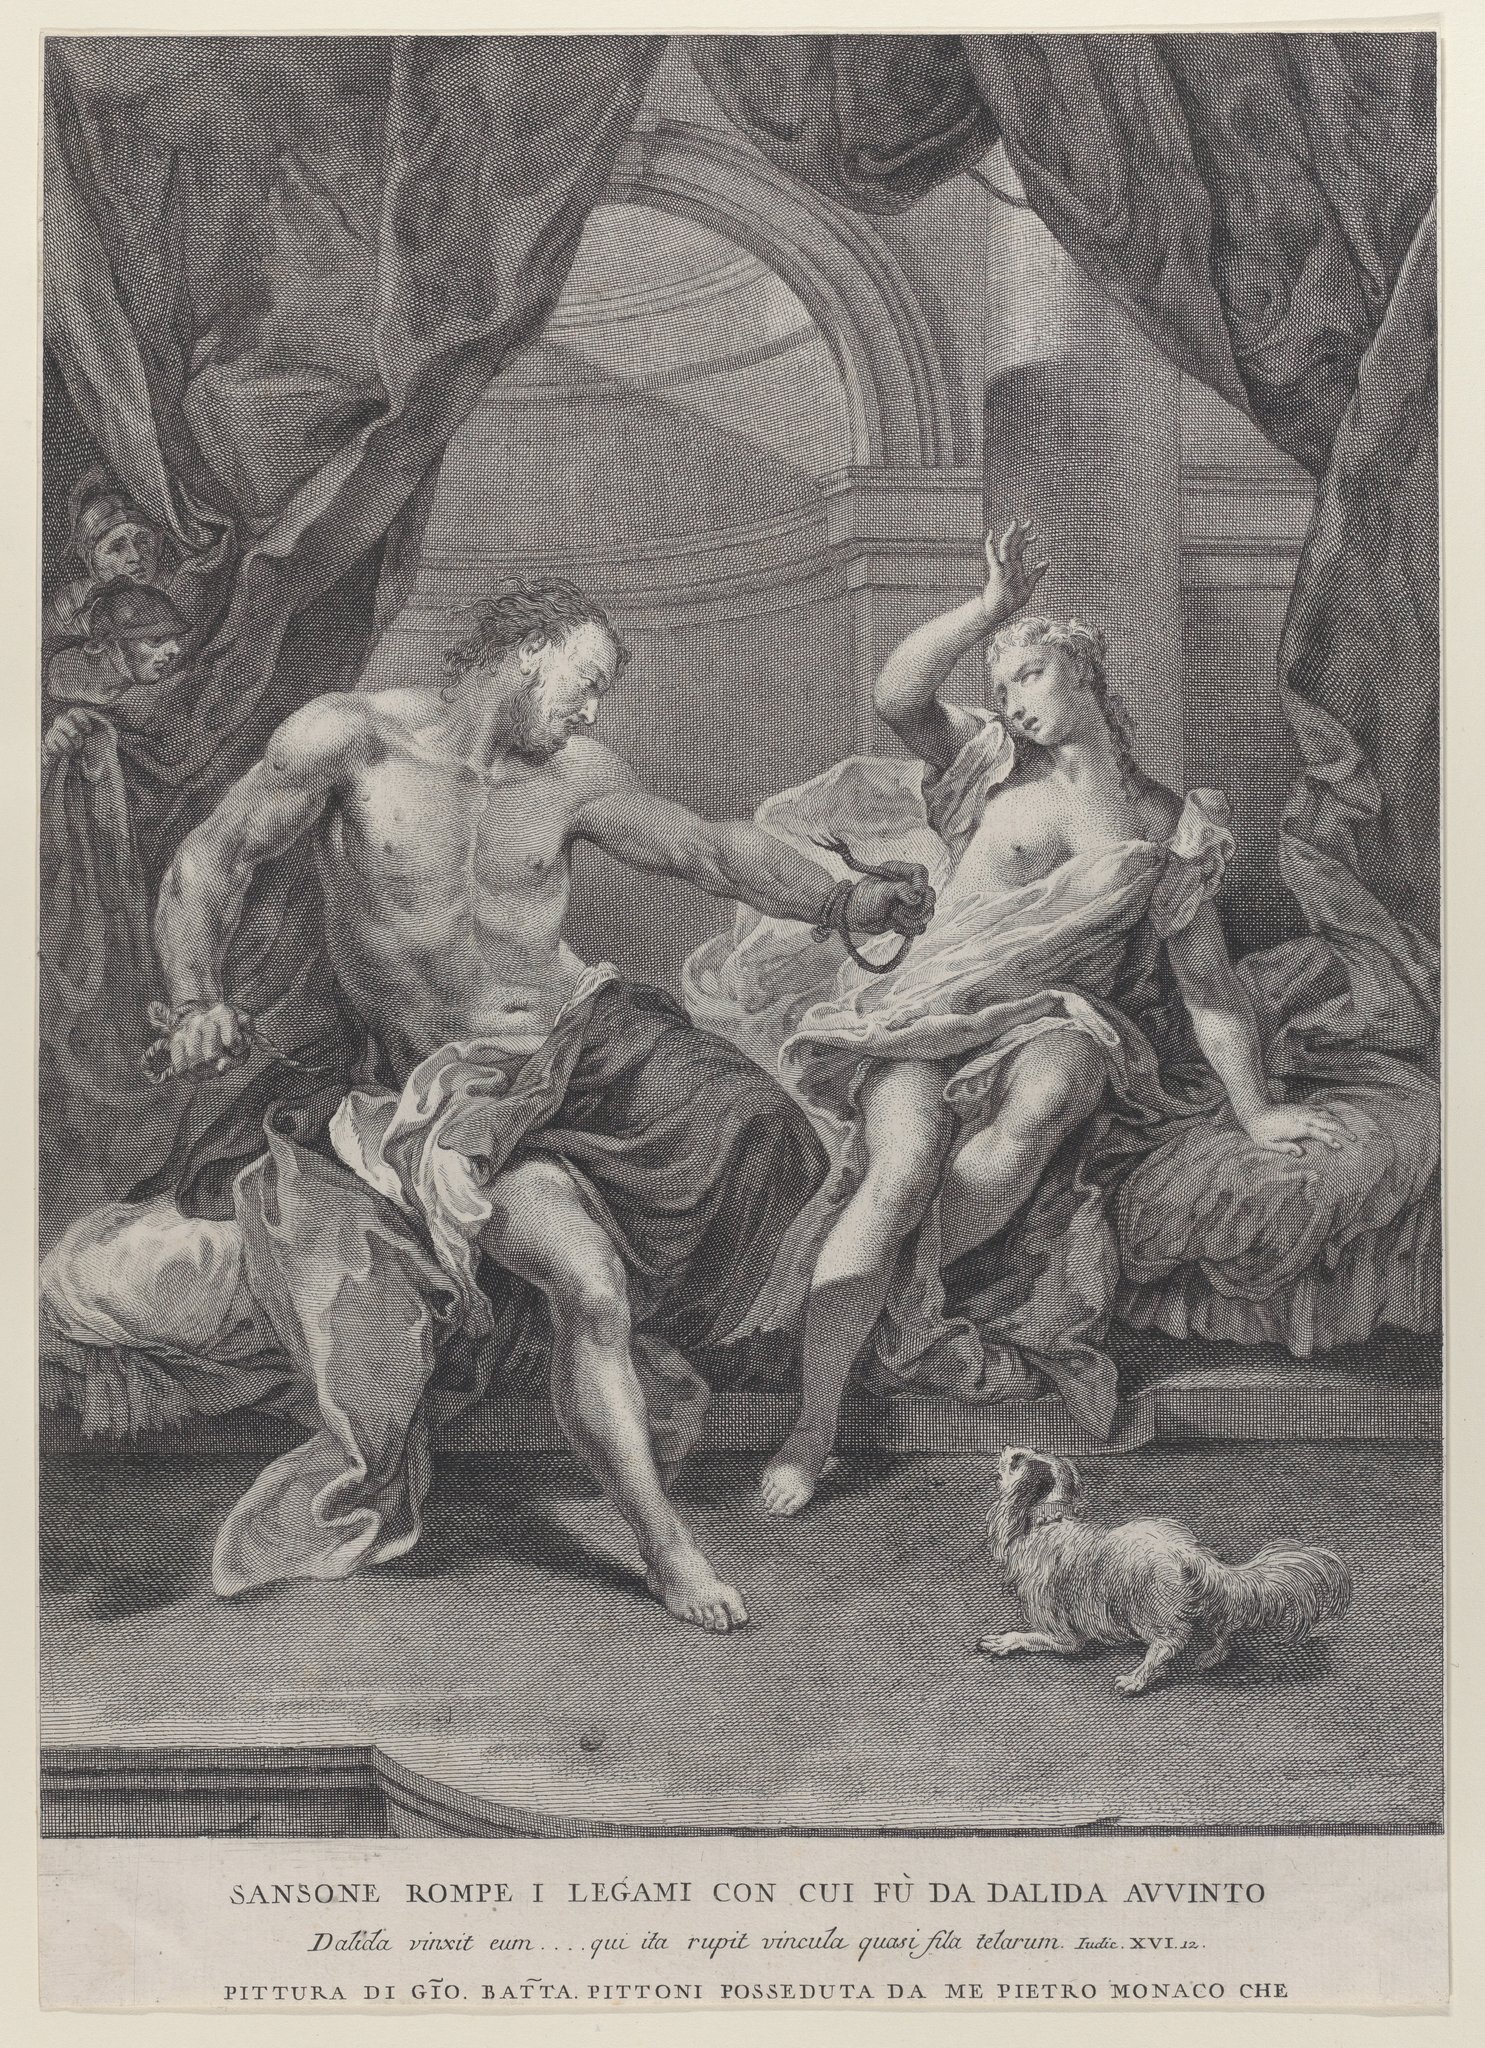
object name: print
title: Samson and Delilah seated on a bed, Samson tearing apart the ropes binding his hands as soldiers look on from behind a curtain; from the series of 112 prints of the sacred history, after the painting by Giovanni Battista Pittoni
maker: pietro monaco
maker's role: artist and publisher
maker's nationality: italian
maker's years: 1707-1772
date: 1730-1739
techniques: engraving, etching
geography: venice